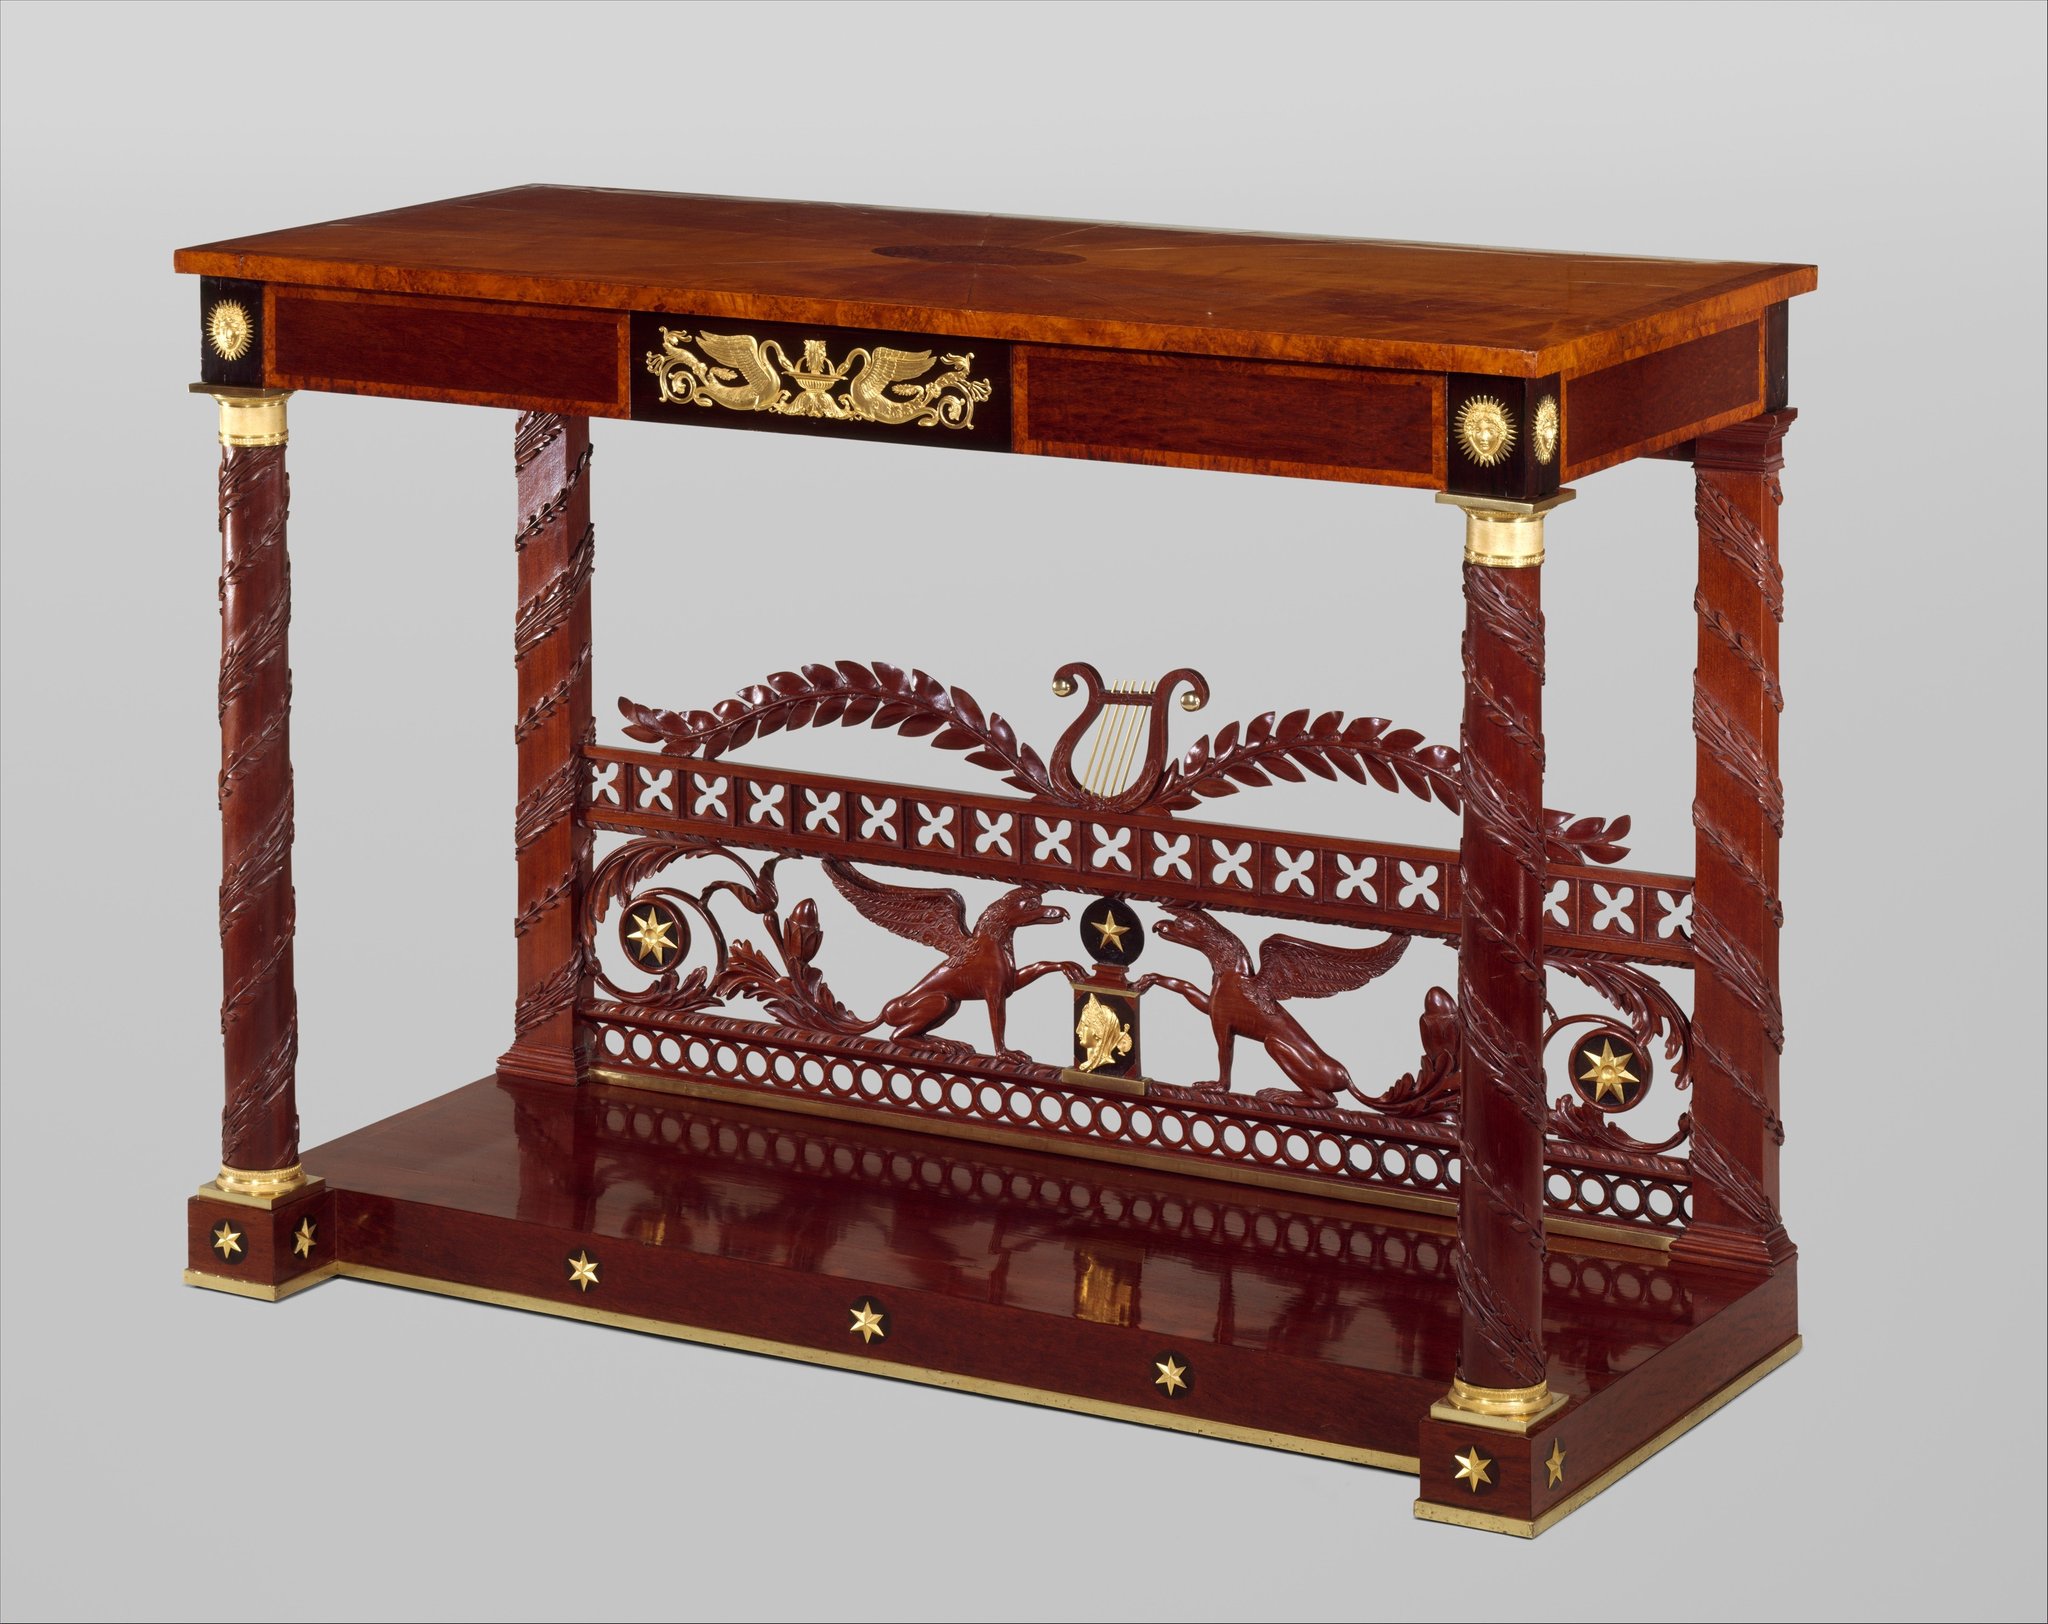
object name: pier table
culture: american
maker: joseph b. barry and son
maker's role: maker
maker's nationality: american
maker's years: 1757-1838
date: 1810-1815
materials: gilt bronze, wood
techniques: veneering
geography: united states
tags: griffins,swans